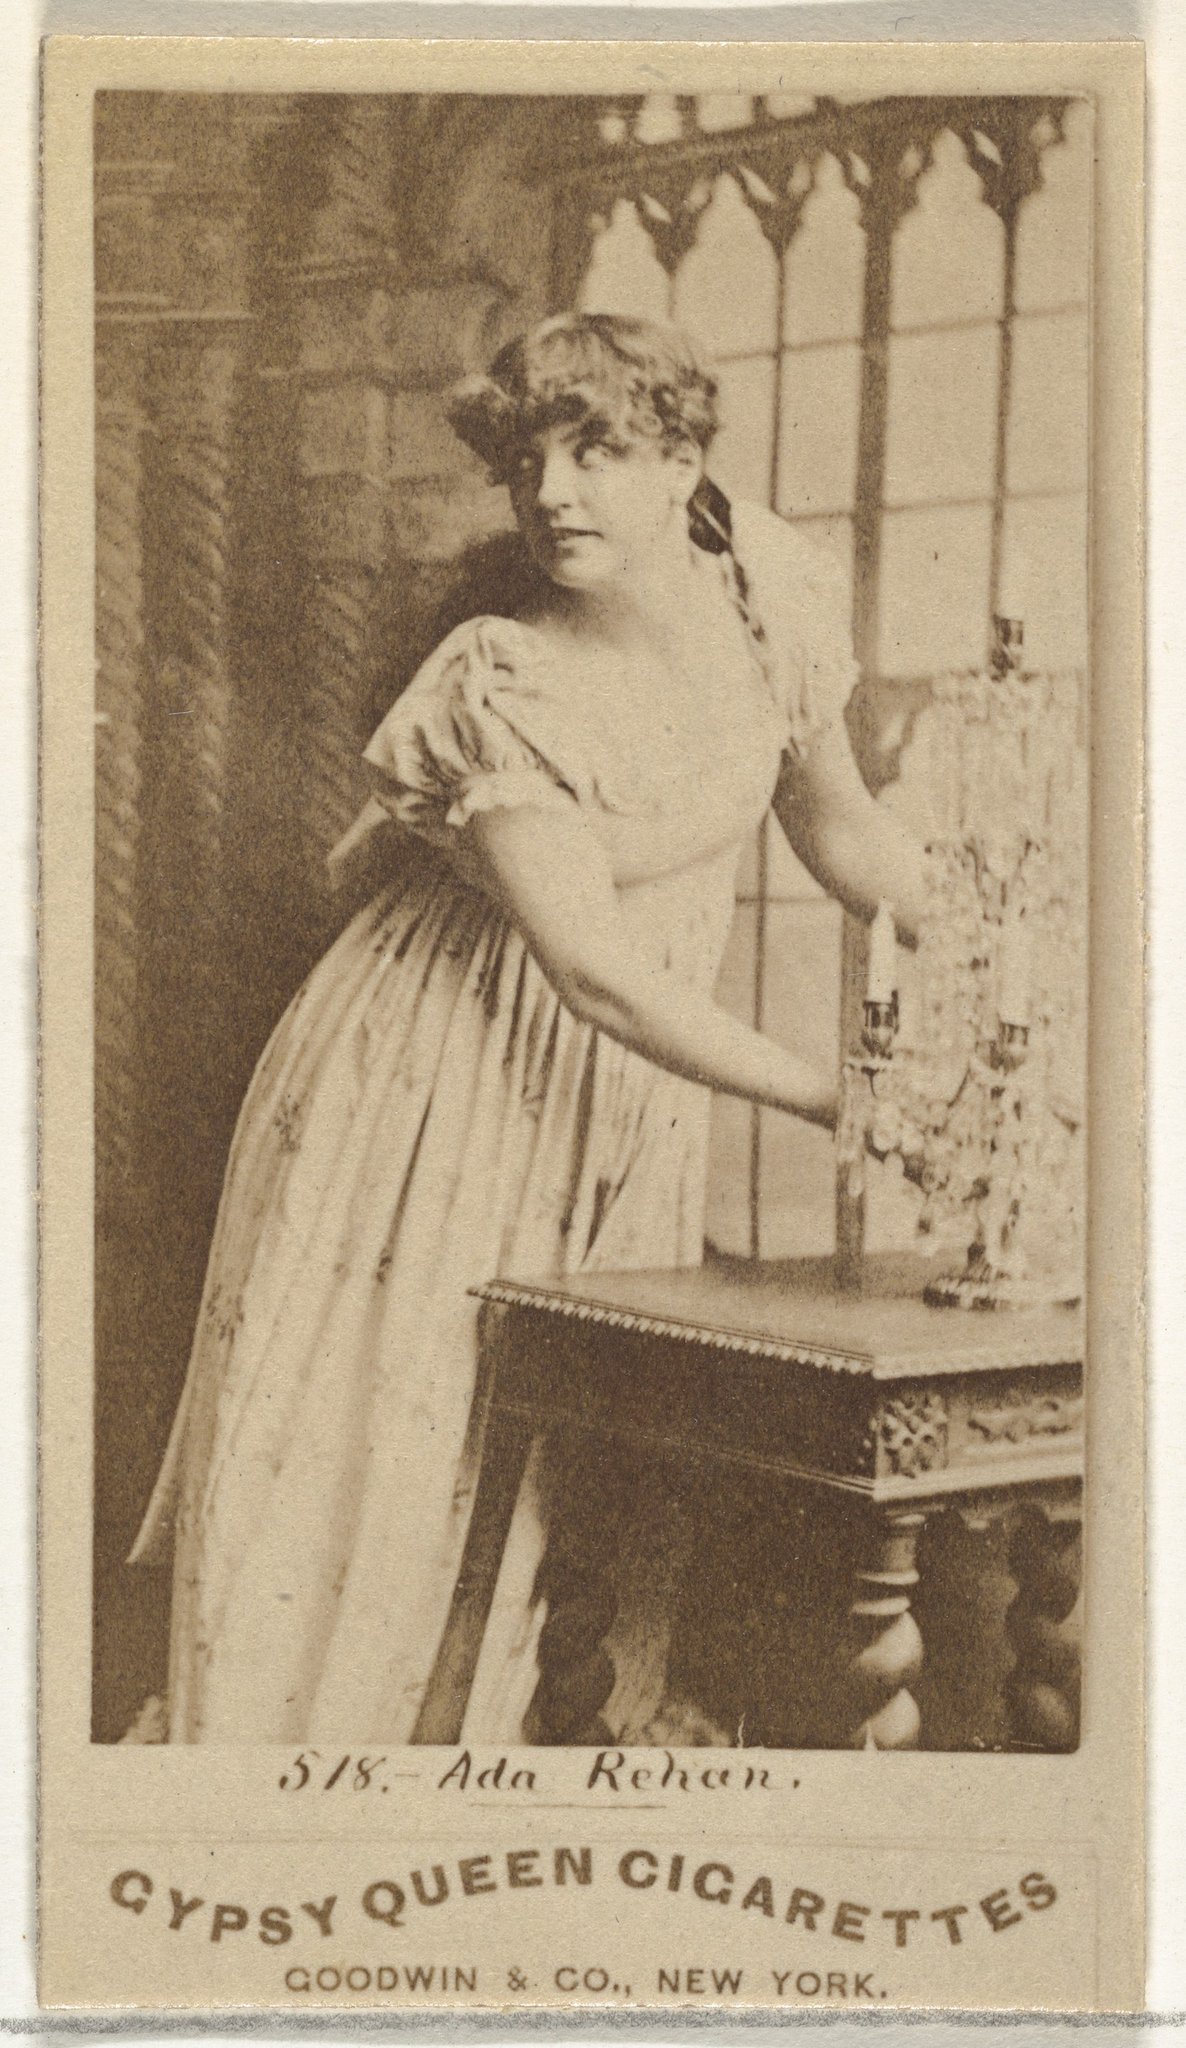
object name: photograph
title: Ada Rehan, from the Actors and Actresses series (N171) for Gypsy Queen Cigarettes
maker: goodwin & company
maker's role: publisher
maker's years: 1850-1950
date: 1886-1890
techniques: albumen silver print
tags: portraits,women,actresses